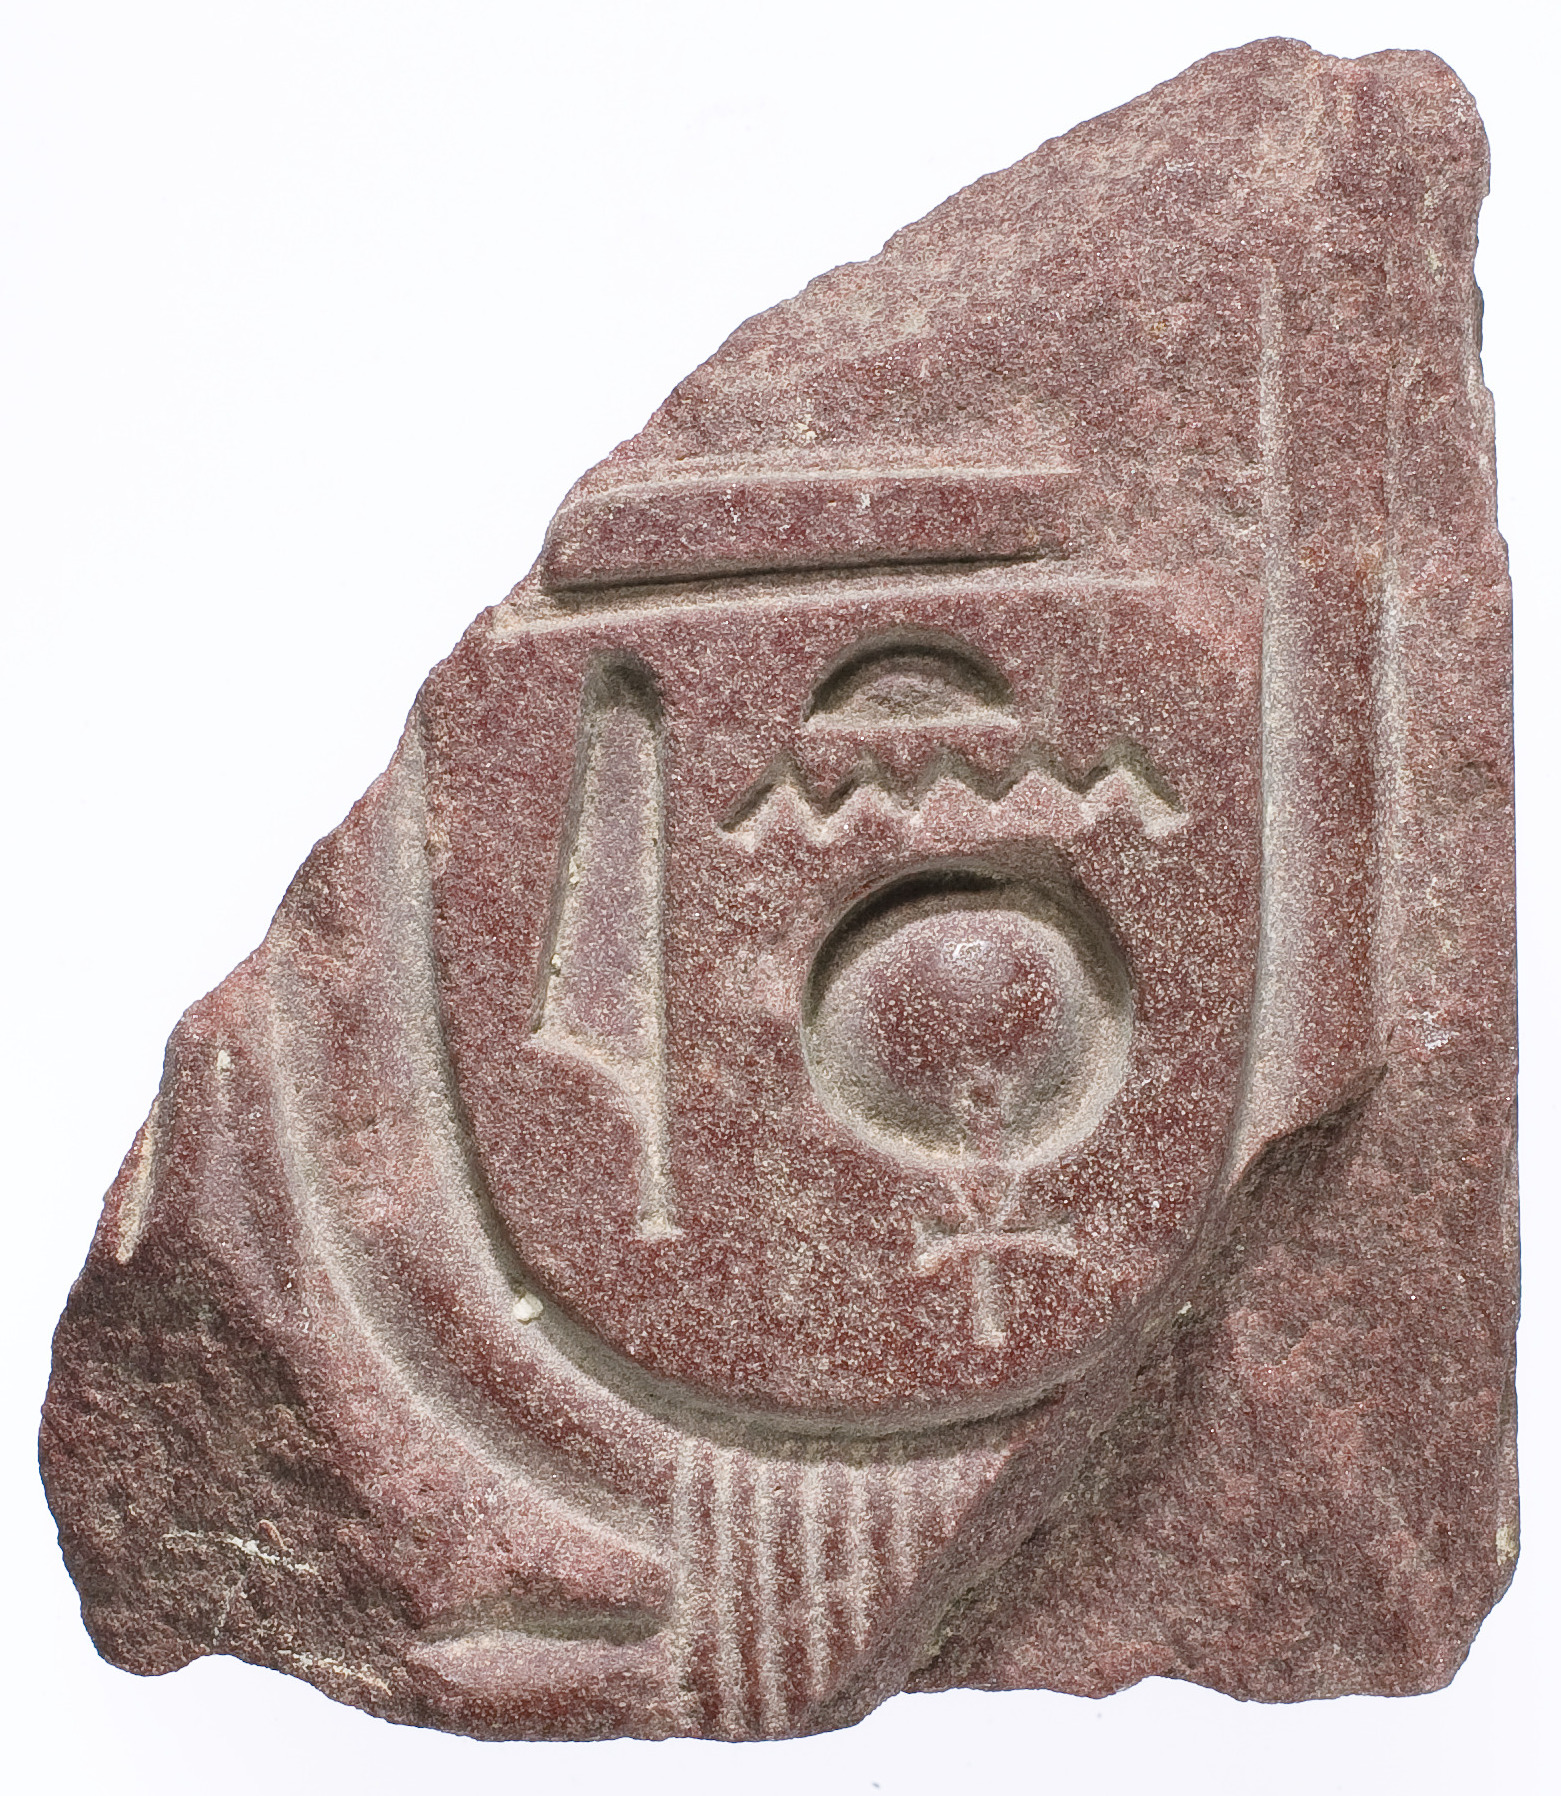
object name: small block, name of akhenaten, nefertiti, aten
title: Part of a small block with names of the Aten preserved on opposite sides and names of Akhenaten and Nefertiti on one preserved end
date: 1353-1336 BCE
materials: quartzite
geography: egypt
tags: hieroglyphs